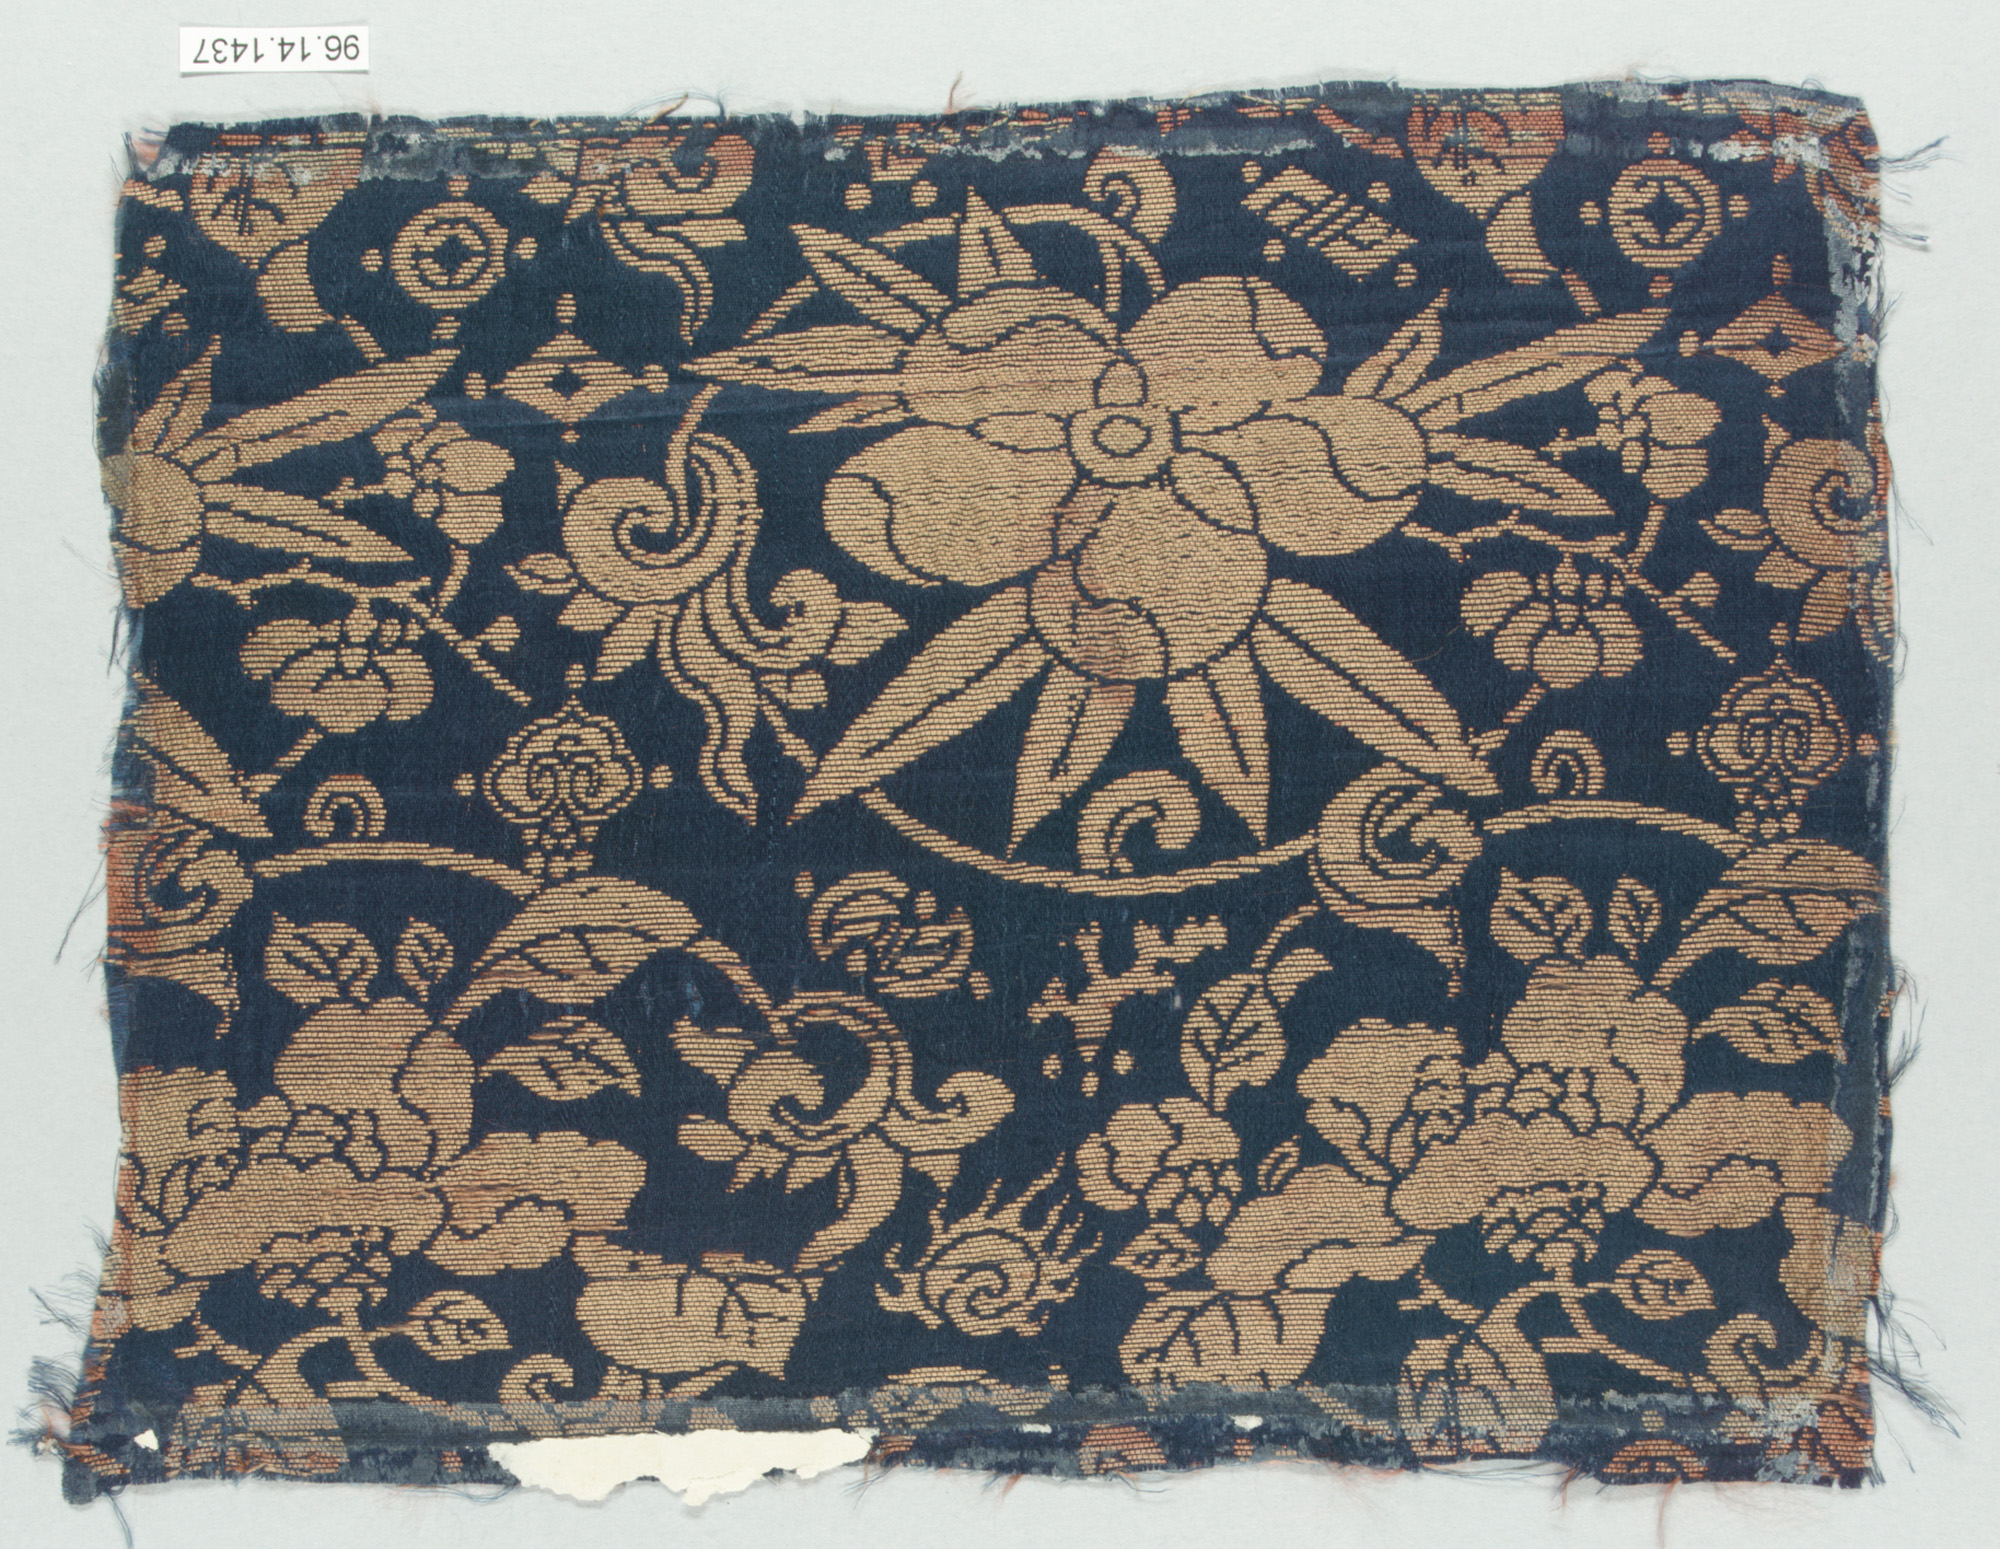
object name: piece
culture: japanese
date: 1801-1900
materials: silk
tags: leaves